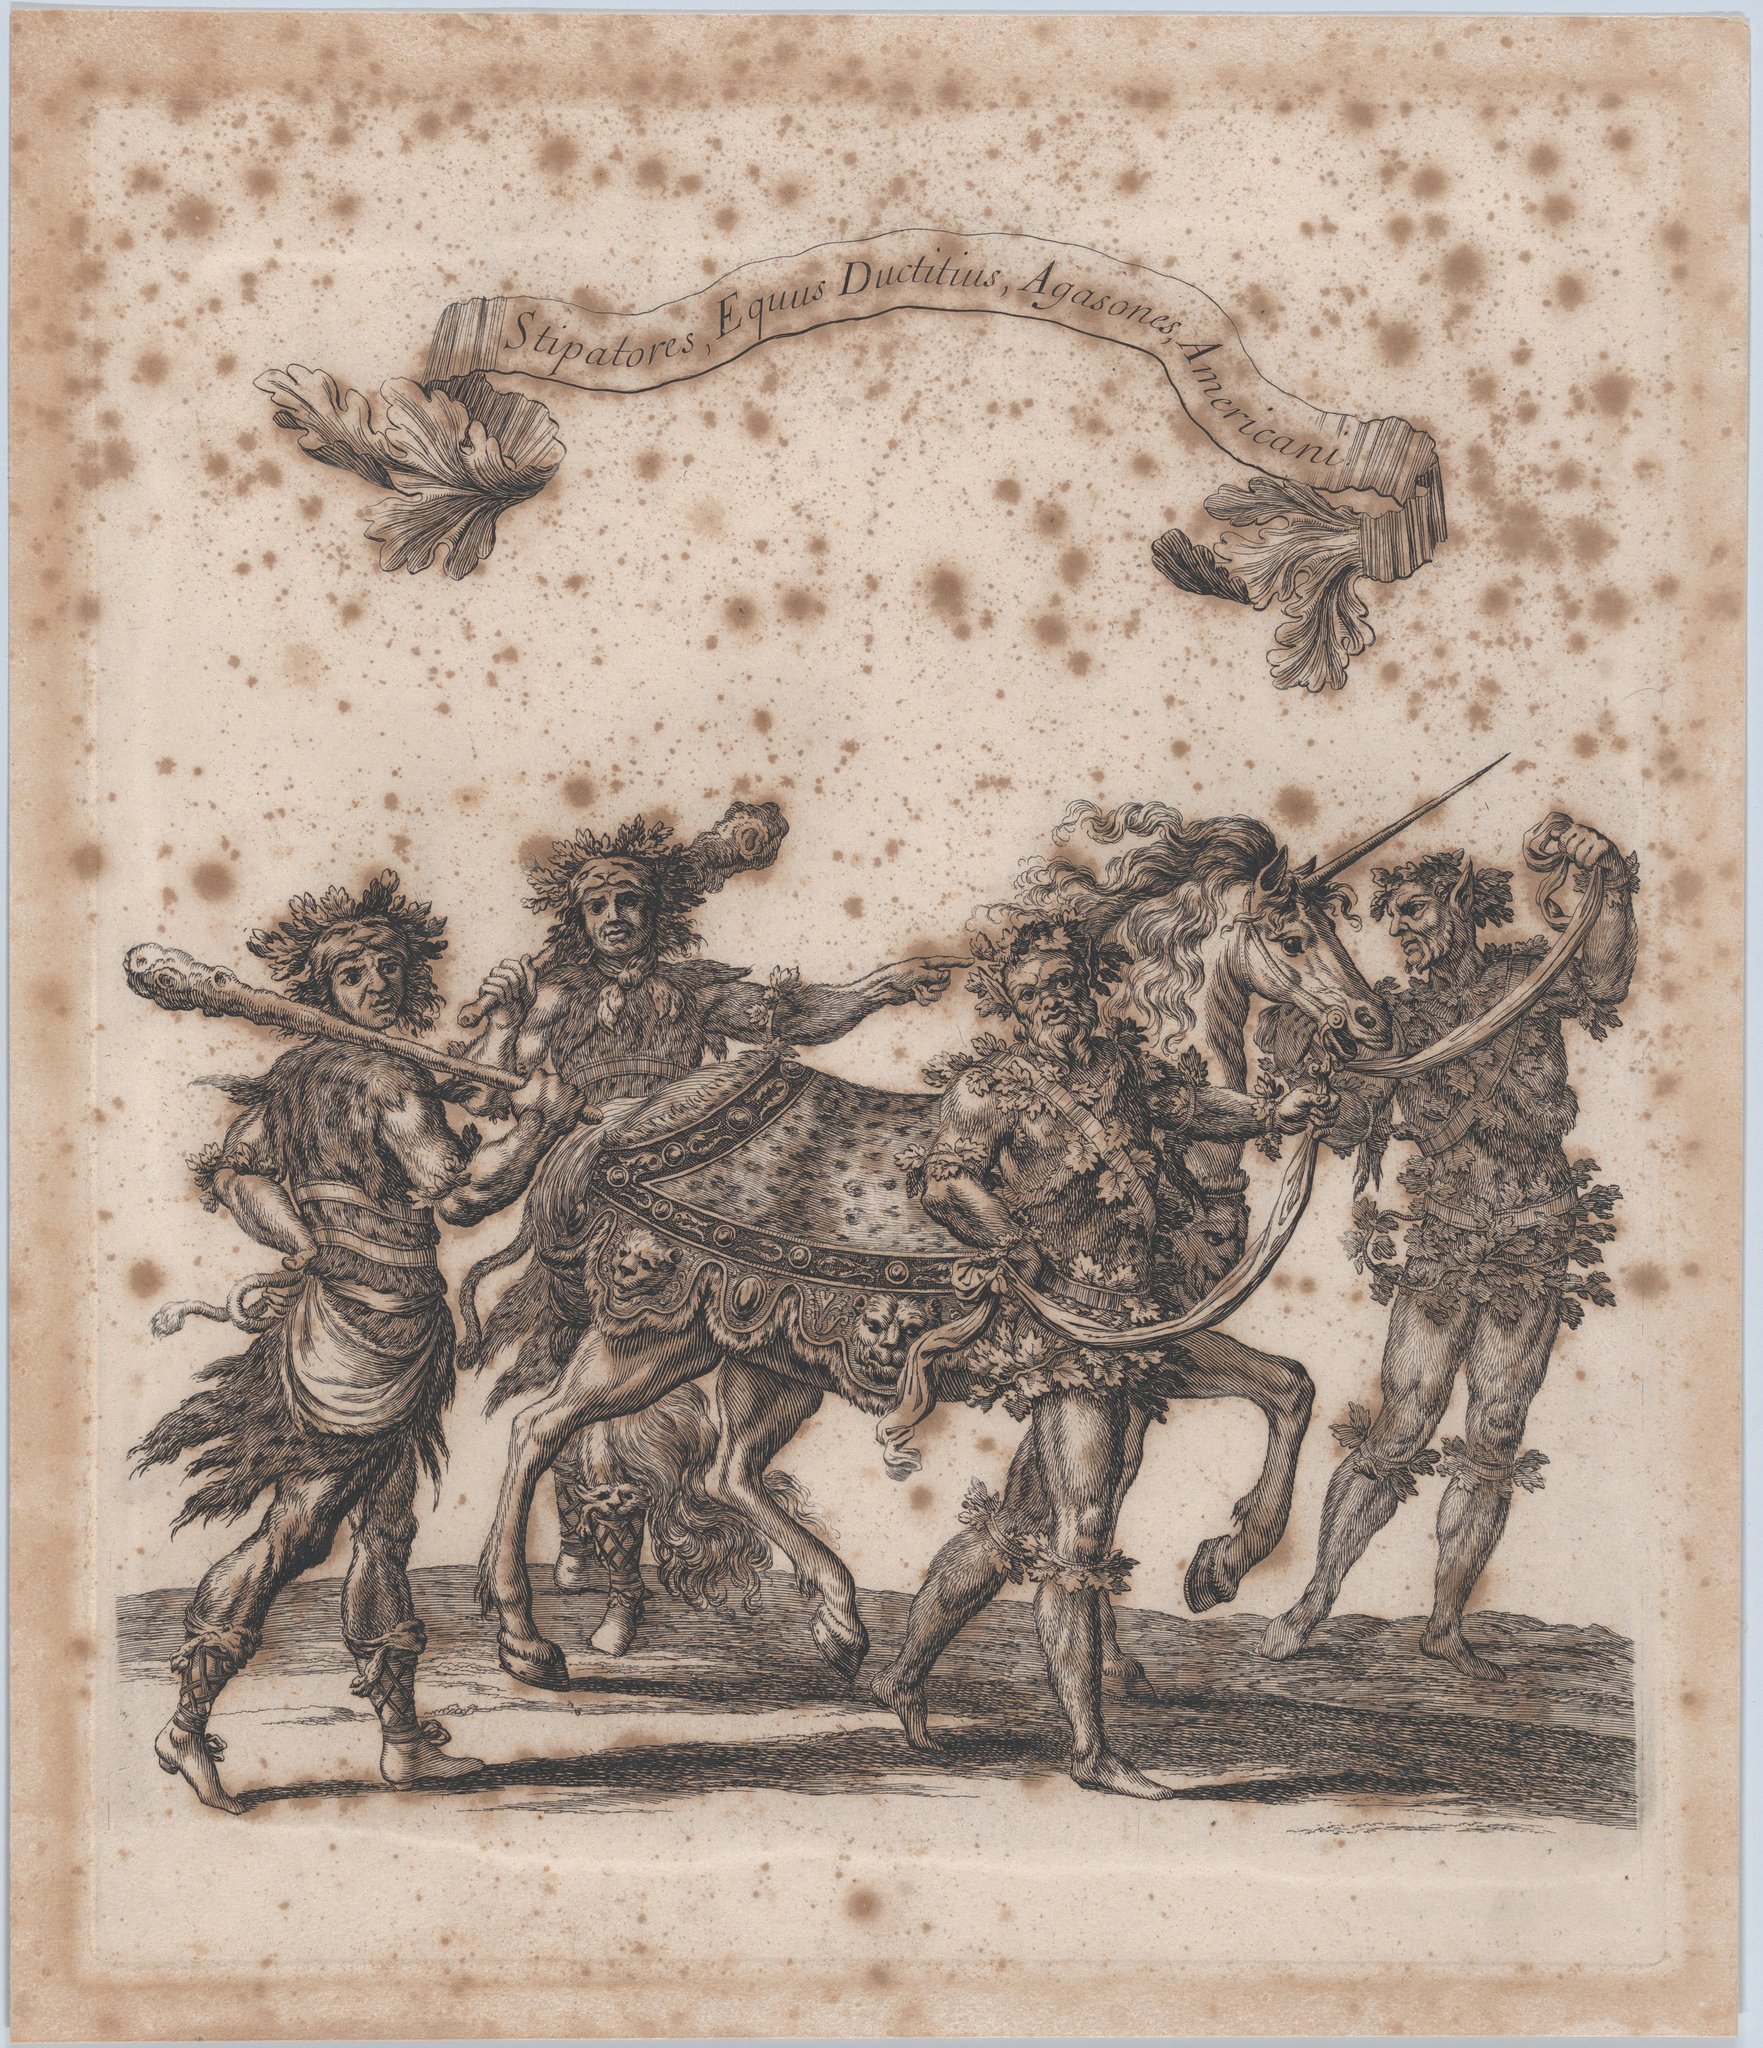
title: Stipatores, Equus Ductitius, Agasones, Americani, from "Courses de Testes et de Bagues Faittes par Roy et par les Princes et Signeurs de sa Cour, en l'annee 1662" (Grand Carrousel)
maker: françois chauveau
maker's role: artist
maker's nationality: french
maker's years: 1613-1676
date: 1662-1670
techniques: etching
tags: louis xiv,men,unicorns